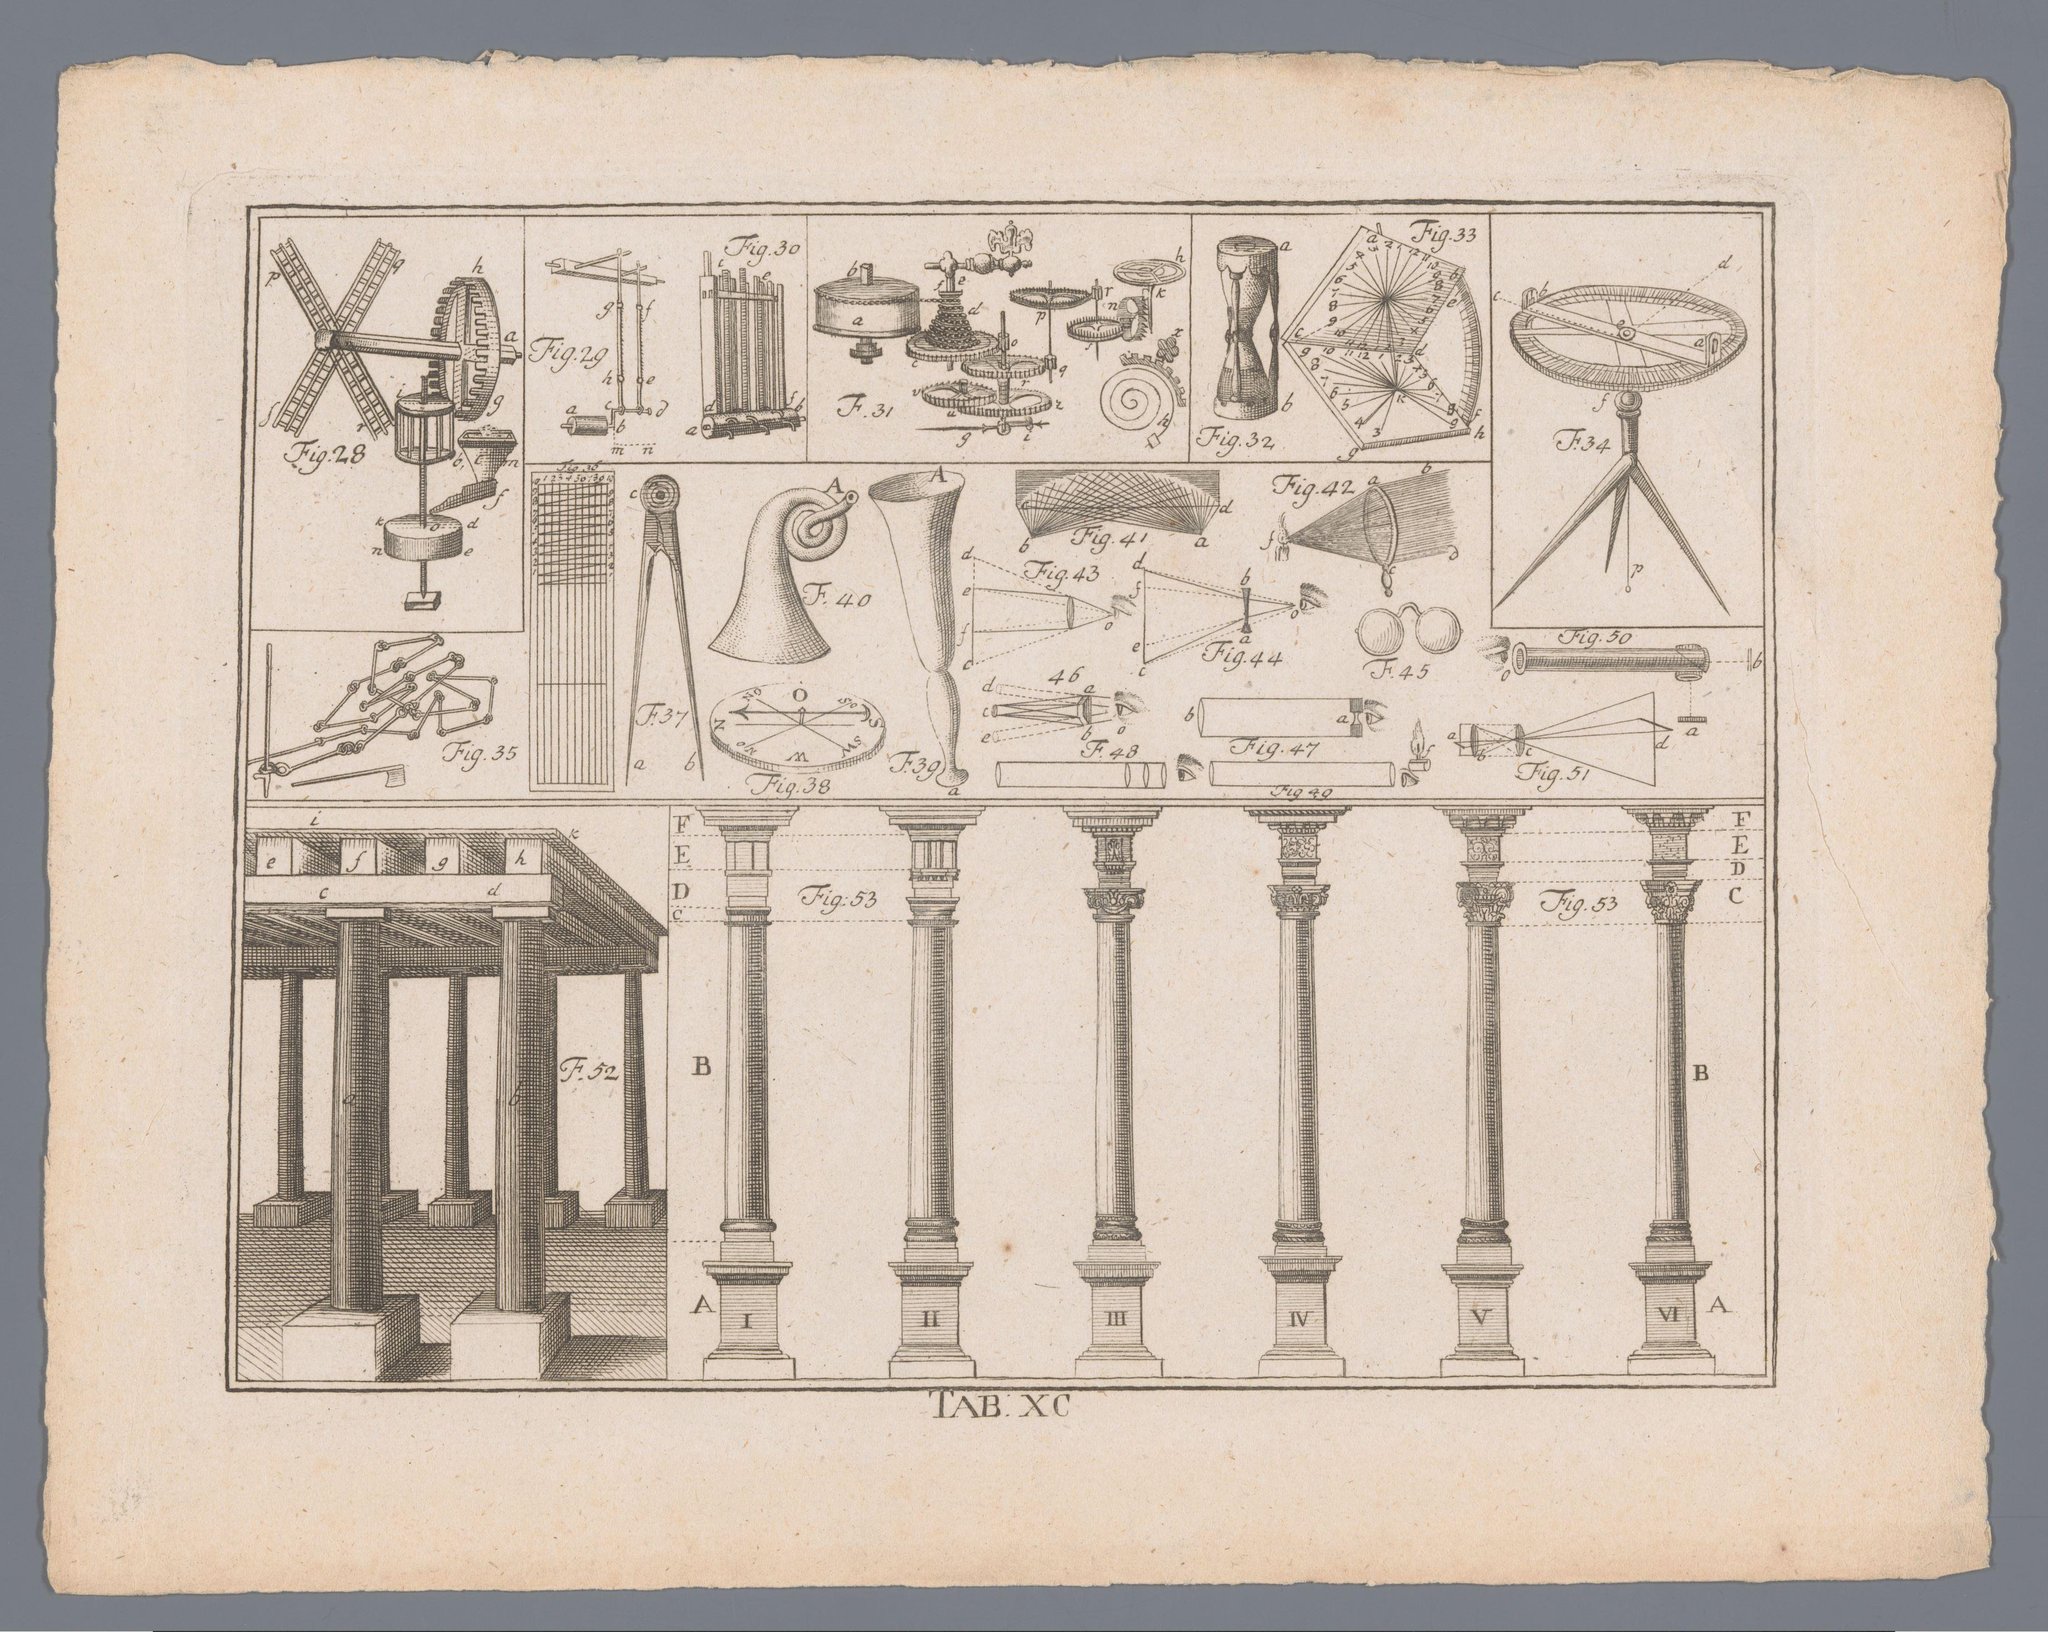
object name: print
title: Zur Maschinenkenntnis und zur Baukunst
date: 1774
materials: paper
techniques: etching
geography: germany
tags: physics, orders, order-books ~ architecture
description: Prent ook gebruikt in: Basedow, Johann Bernhard. Das Basedowische Elementarwerk. Ein Vorrath der besten Erkenntnisse zum Lernen, Lehren, Wiederholen und Nachdenken. Leipzig: Siegfried Lebrecht Crucius, 1774.